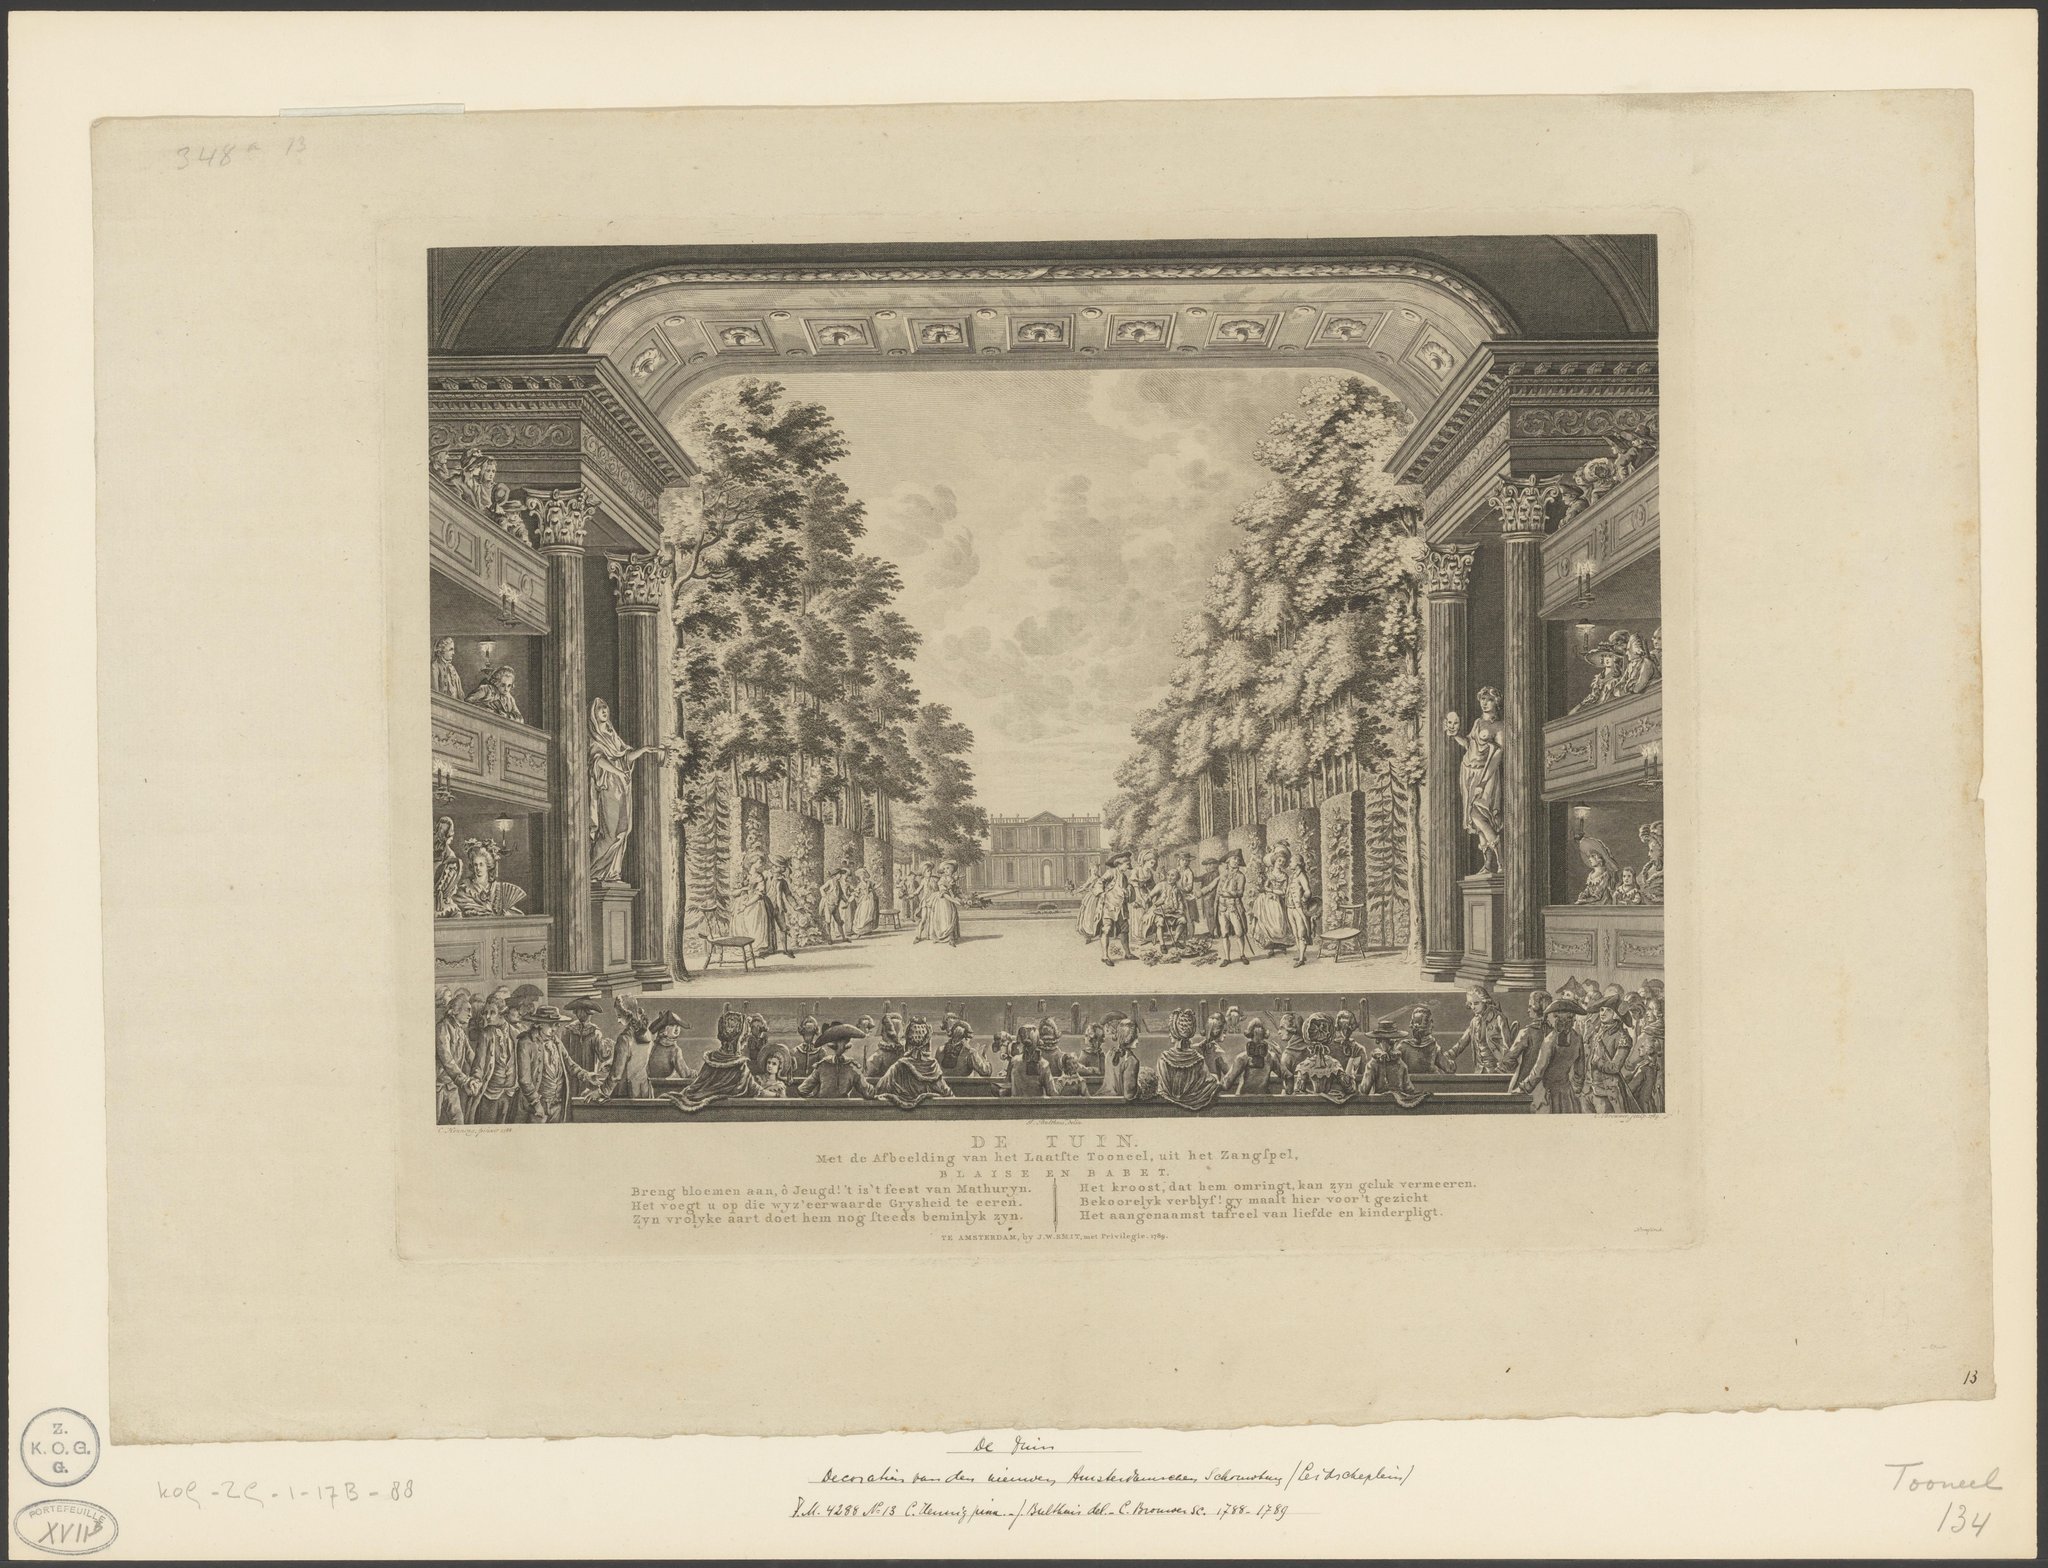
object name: print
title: Toneeldecors van de nieuwe Amsterdamse Schouwburg, 1787-1794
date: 1789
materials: paper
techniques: engraving, etching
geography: amsterdam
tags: theatre, theatrical performance, stage design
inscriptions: stamp, collector's mark: Lugt 1641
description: Toneelvoorstelling in de nieuwe Amsterdamse Schouwburg met het coulissendecor De Tuin, met scène uit Blaise en Babet. Het decor gedrukt van een aparte plaat binnen een vernieuwde passe-partout met de zaal, zijloges, pilaren met standbeelden en de façade van het toneel. In het onderschrift een zesregelig vers. Onderdeel van de serie van veertien toneeldecors van de nieuwe Amsterdamse Schouwburg, 1787-1794. Onderwerpsrubrieken binnen de Atlas Zeden en Gewoonten: Schoone kunsten, Tooneel, Decors voor de Schouwburg.